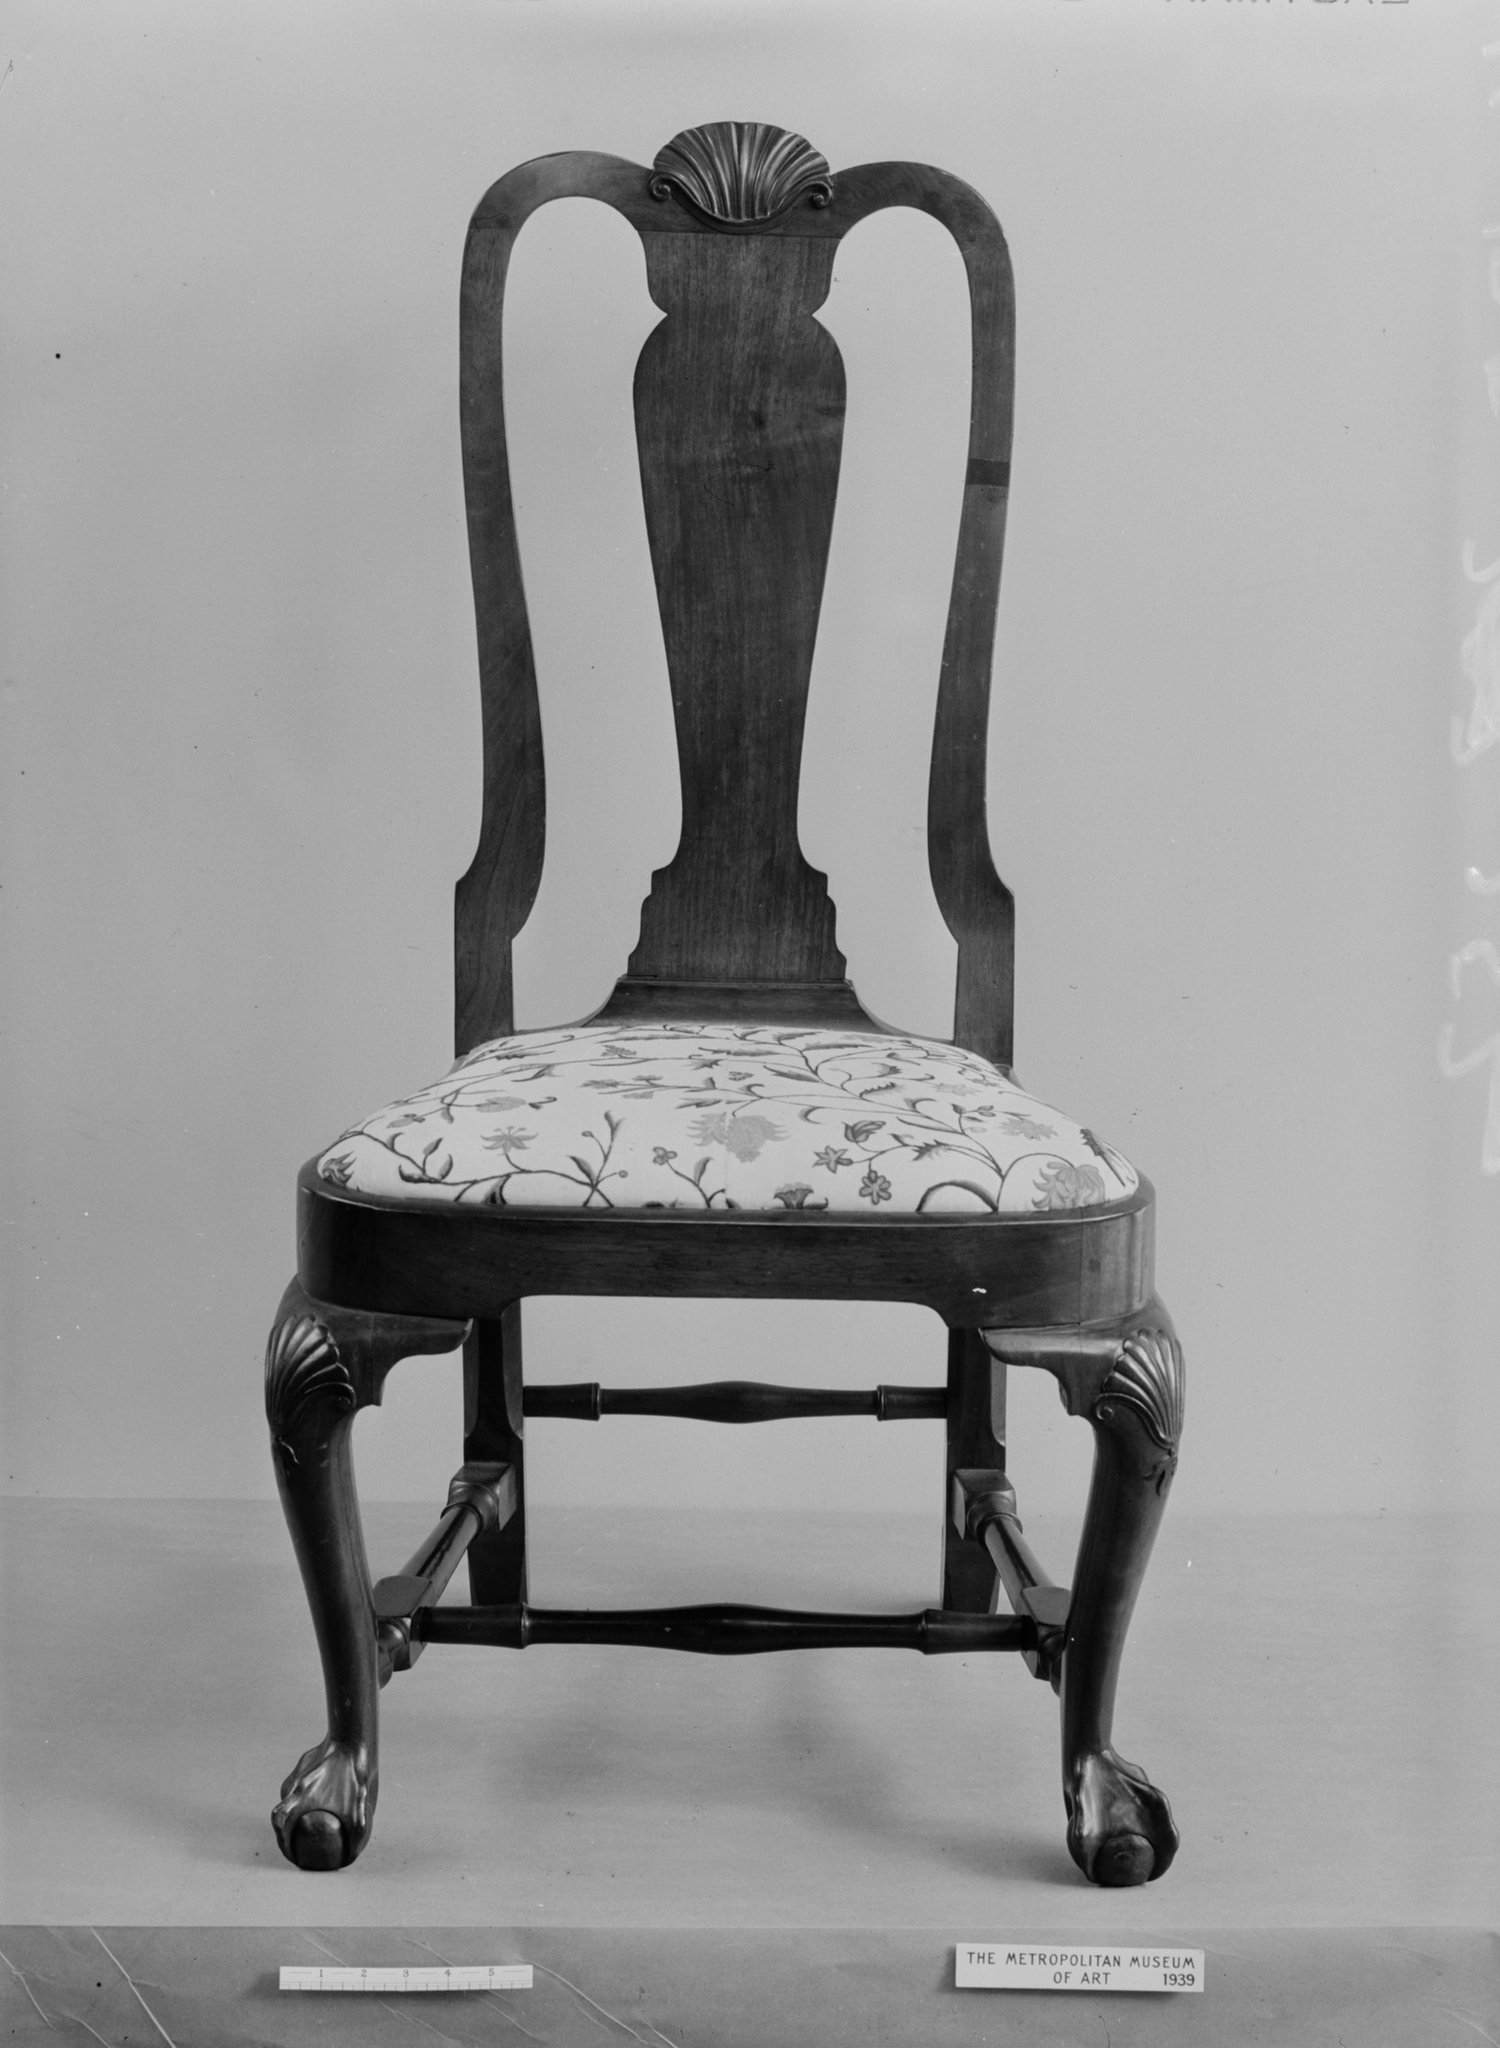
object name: side chair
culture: american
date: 1730-1750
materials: wood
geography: united states